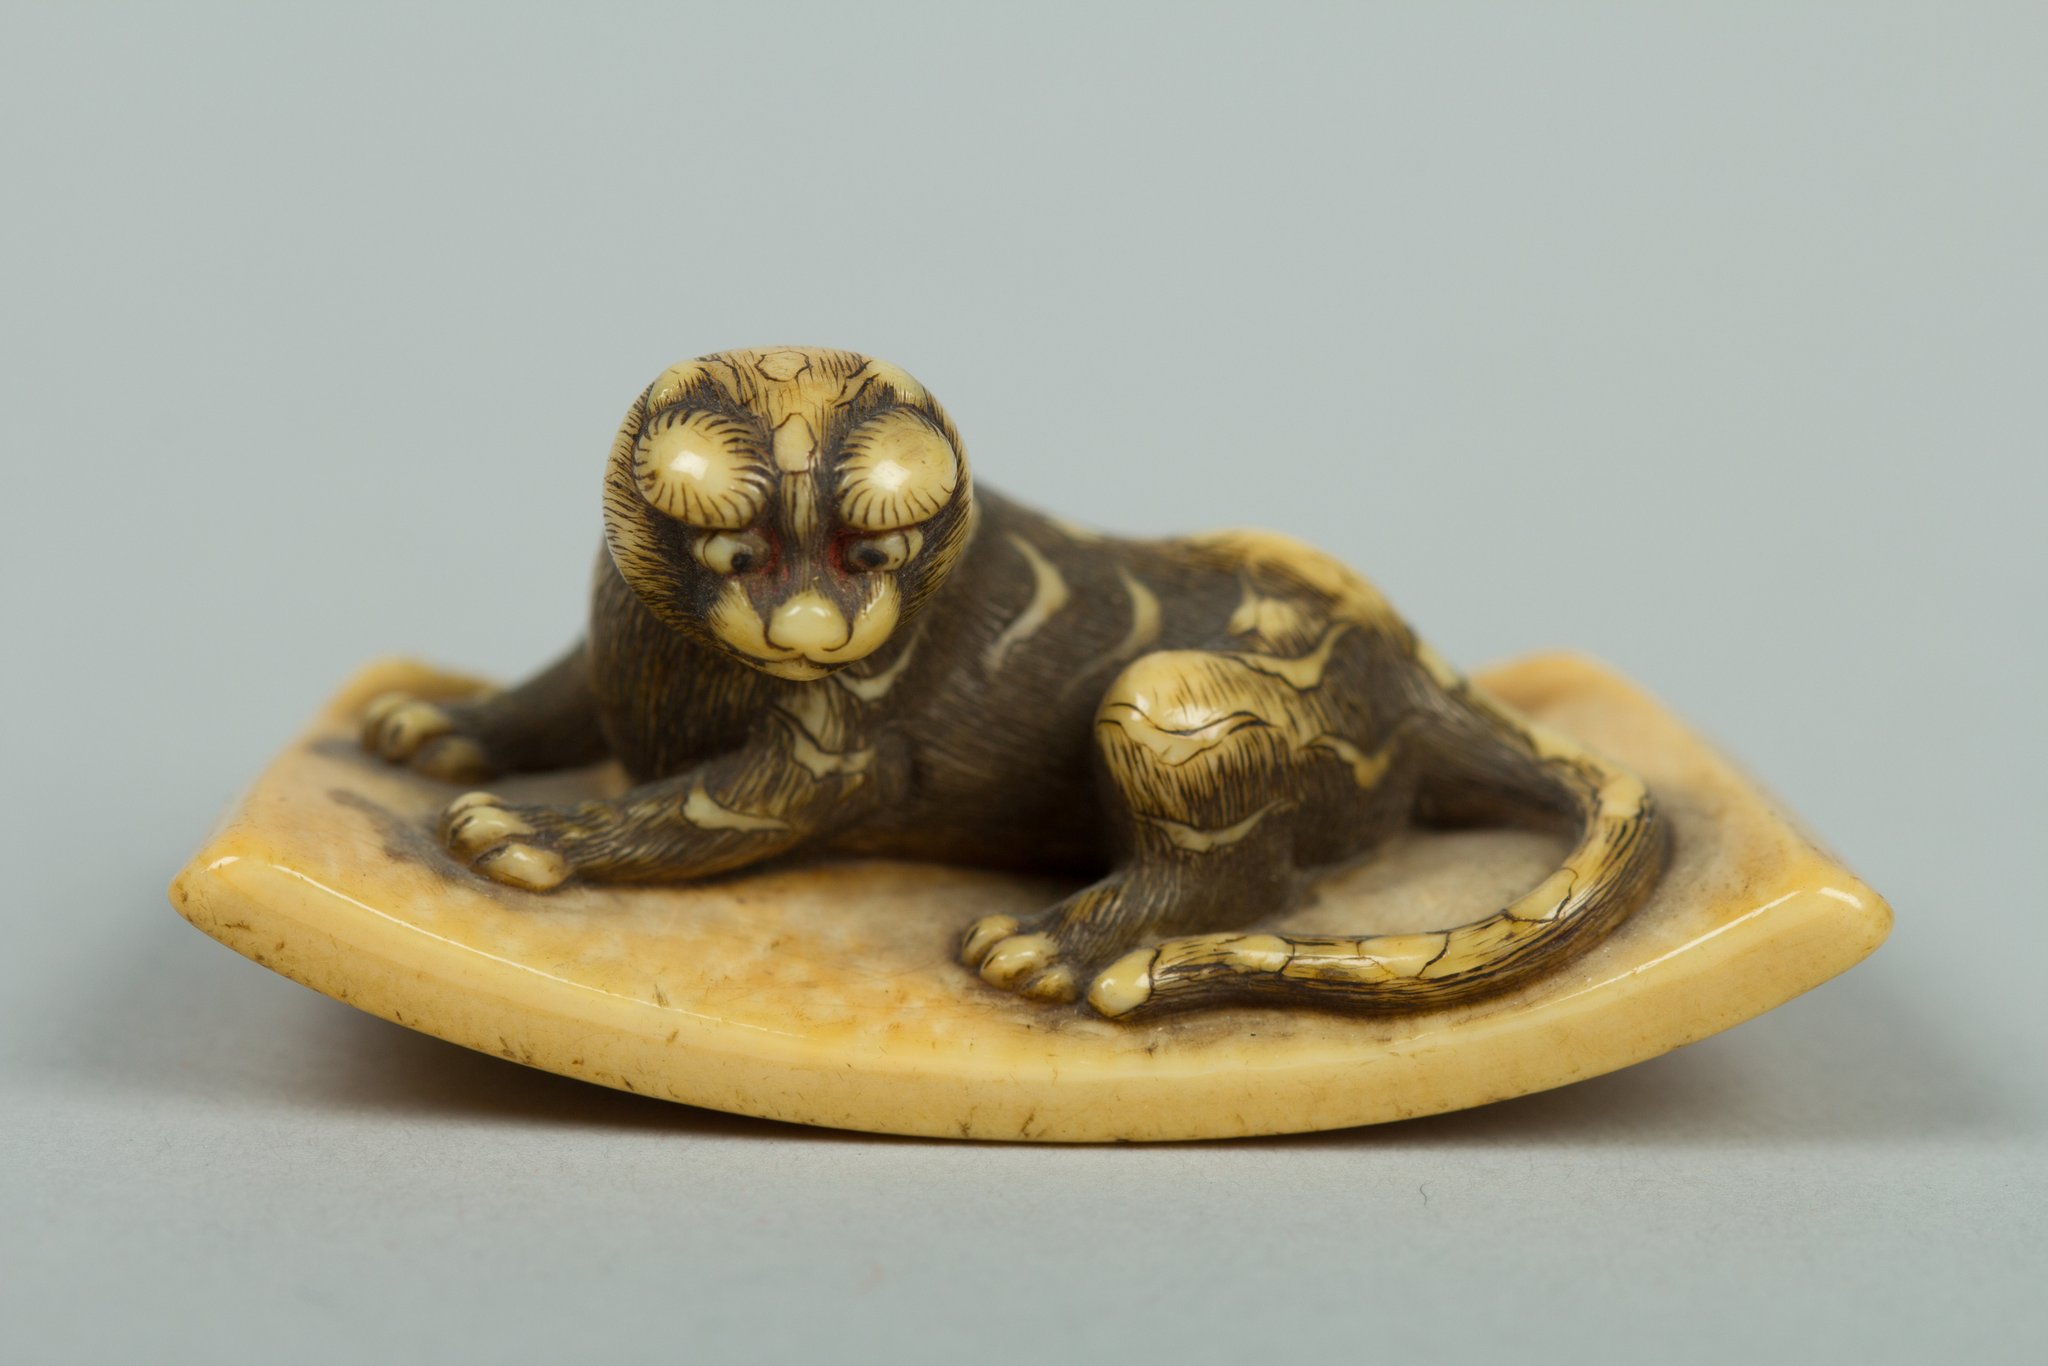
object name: netsuke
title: Netsuke of Tiger Lying on a Mat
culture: japanese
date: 1801-1900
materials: ivory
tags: tigers